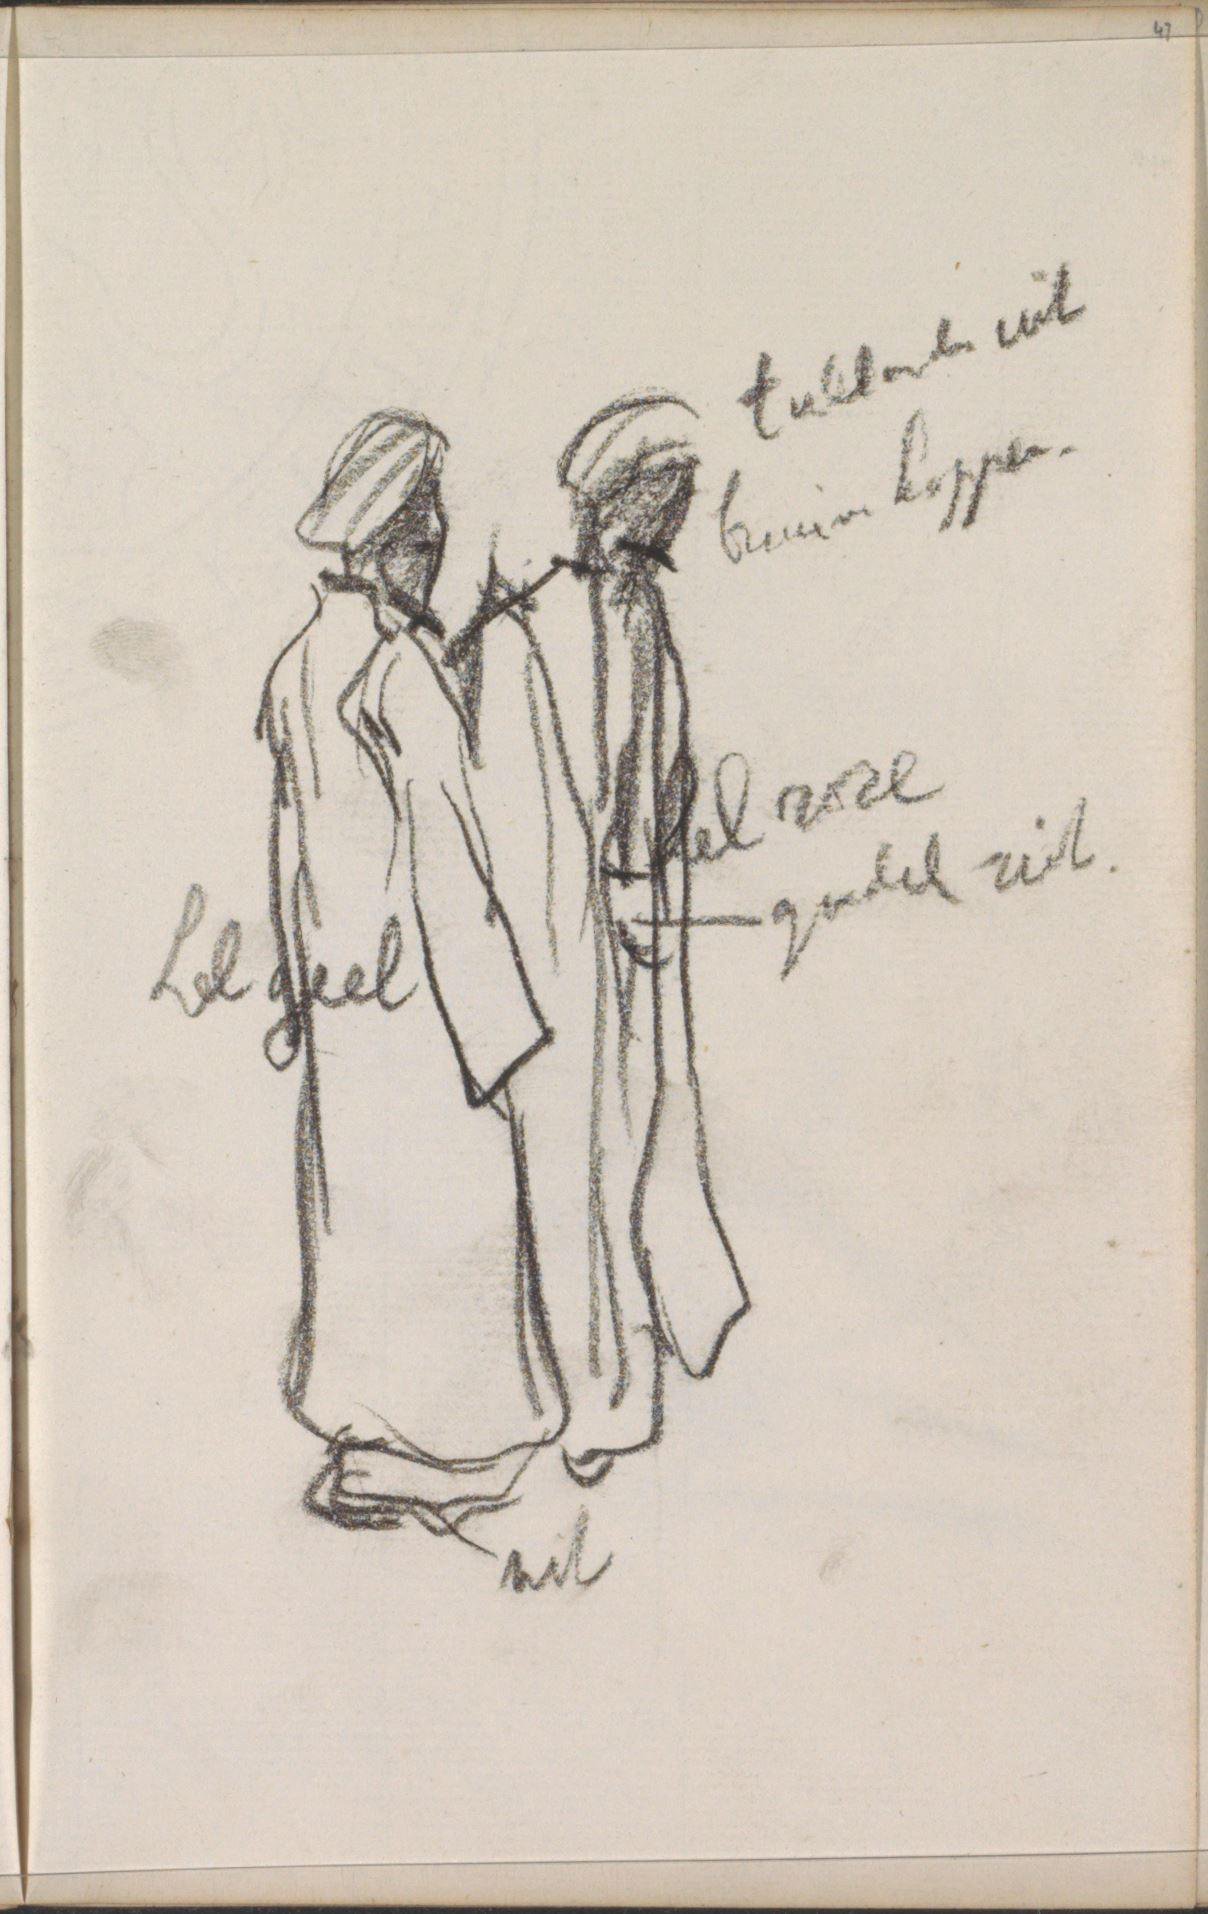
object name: sketchbook leaf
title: Twee oosterse mannen met tulbanden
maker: marius bauer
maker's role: draughtsman, print maker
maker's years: 1867-1932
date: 1899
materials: chalk, paper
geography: turkey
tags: asiatic races and peoples, adult man, head-gear: turban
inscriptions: kleurnotitie, handgechreven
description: Pagina 47 uit een schetsboek met 42 bladen.